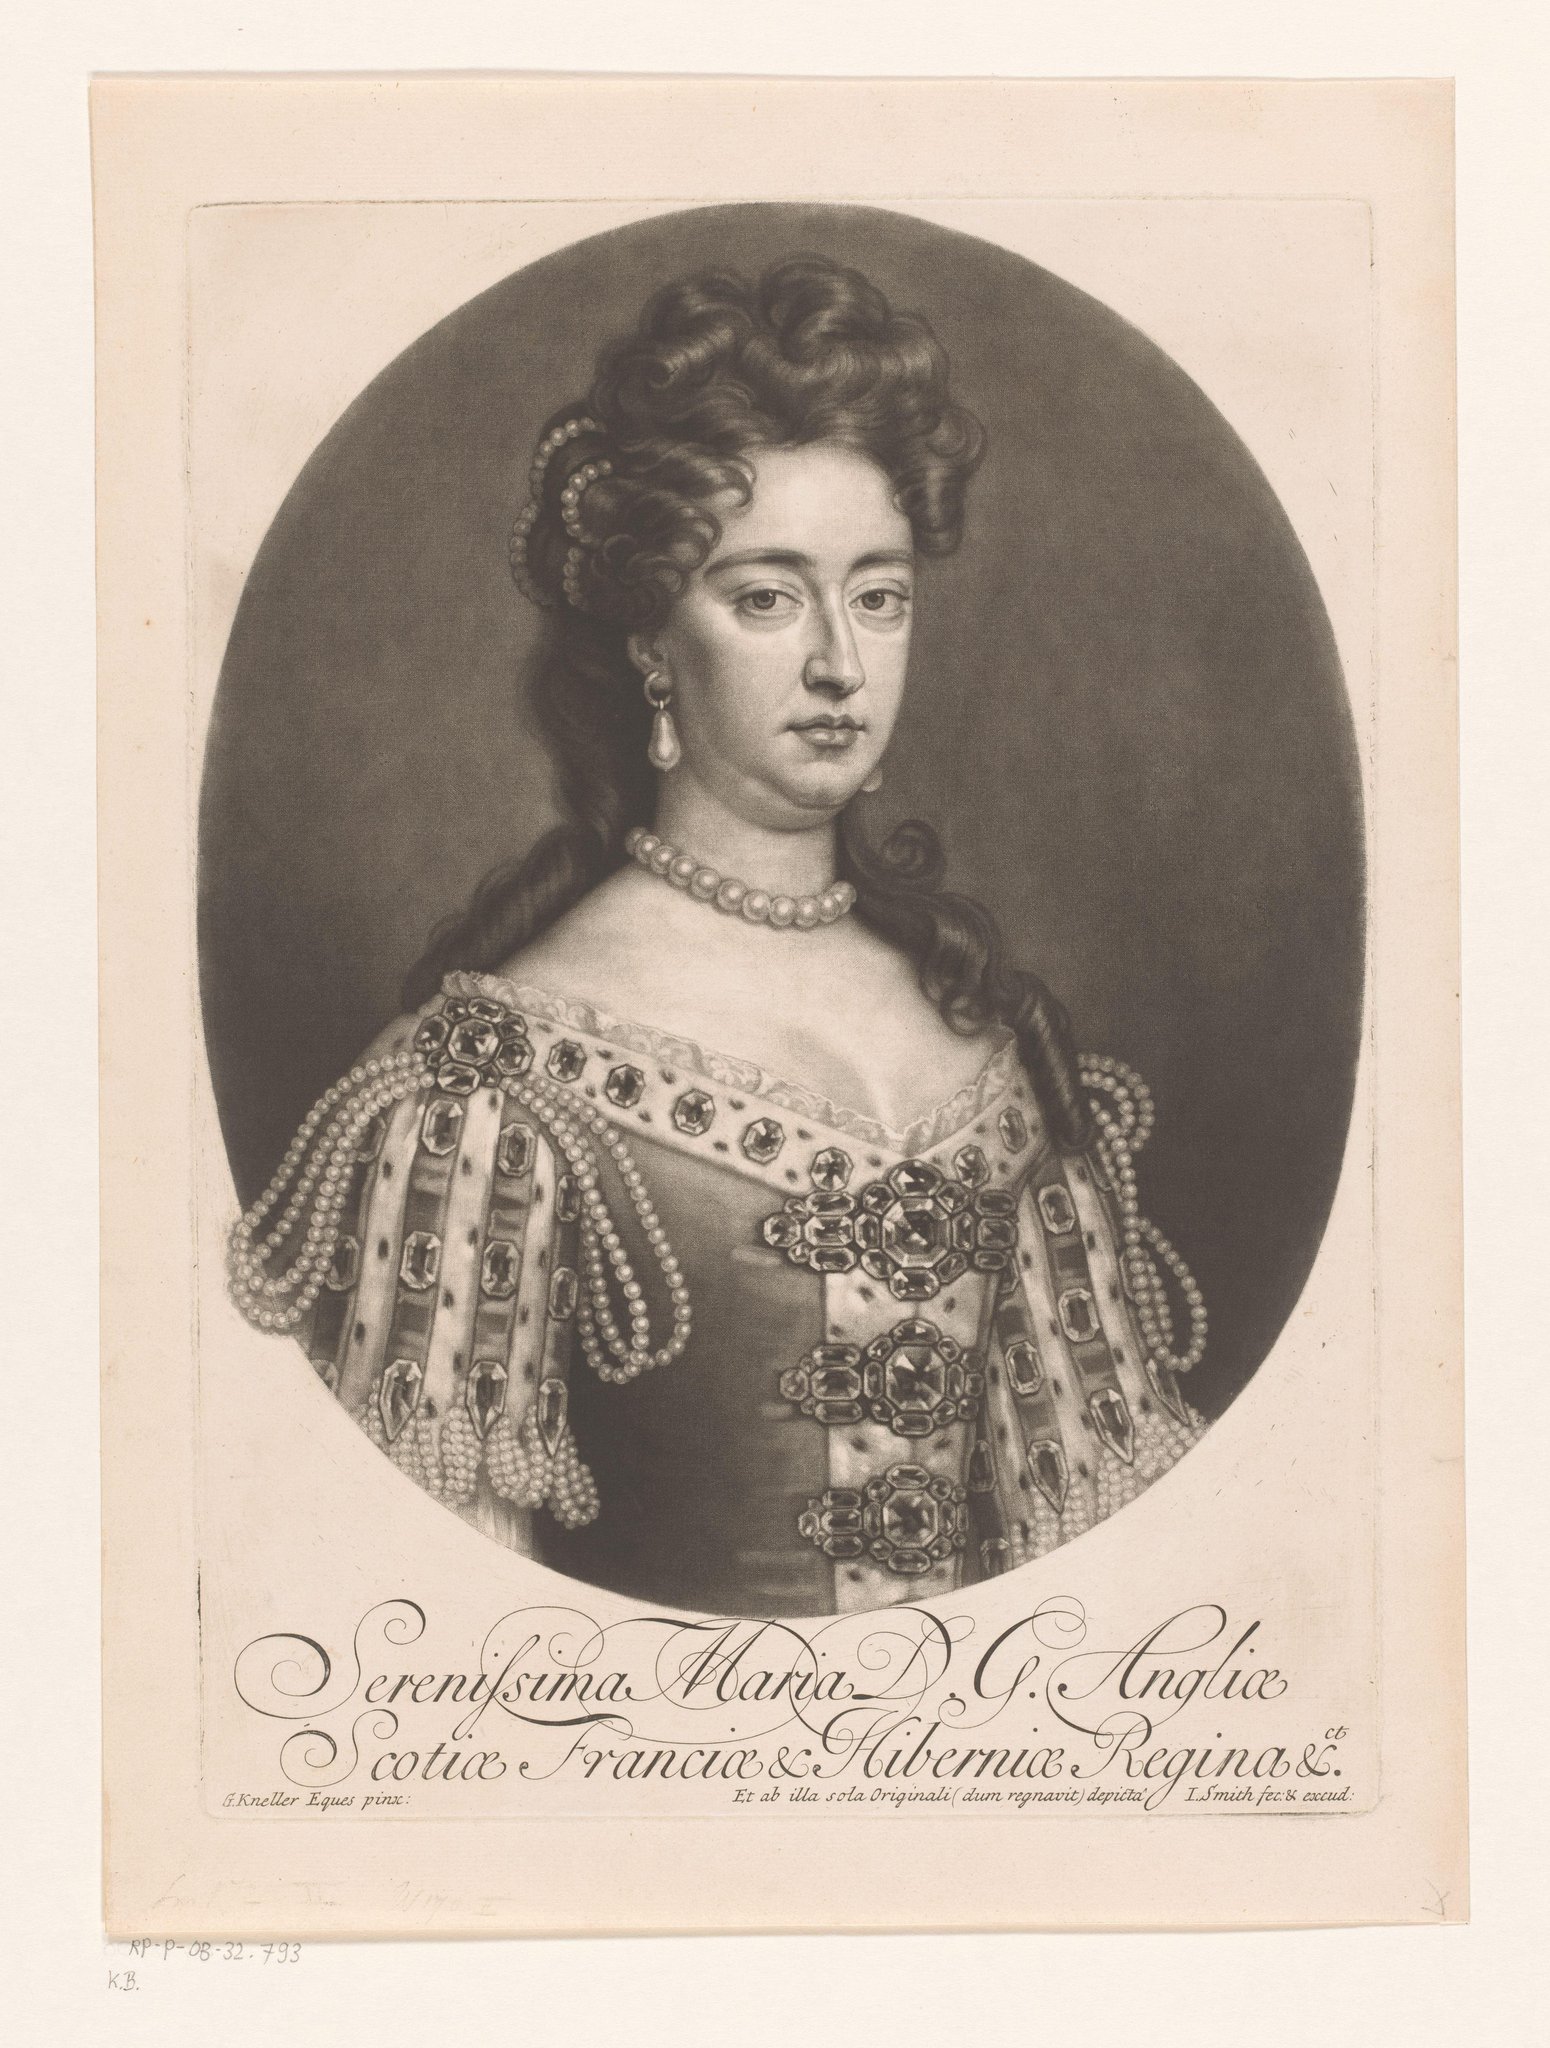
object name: print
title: Portret van Maria van Modena, koningin van Engeland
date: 1685-1742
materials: paper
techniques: mezzotint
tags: paris, historical persons, queen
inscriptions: collector's mark: Lugt 240